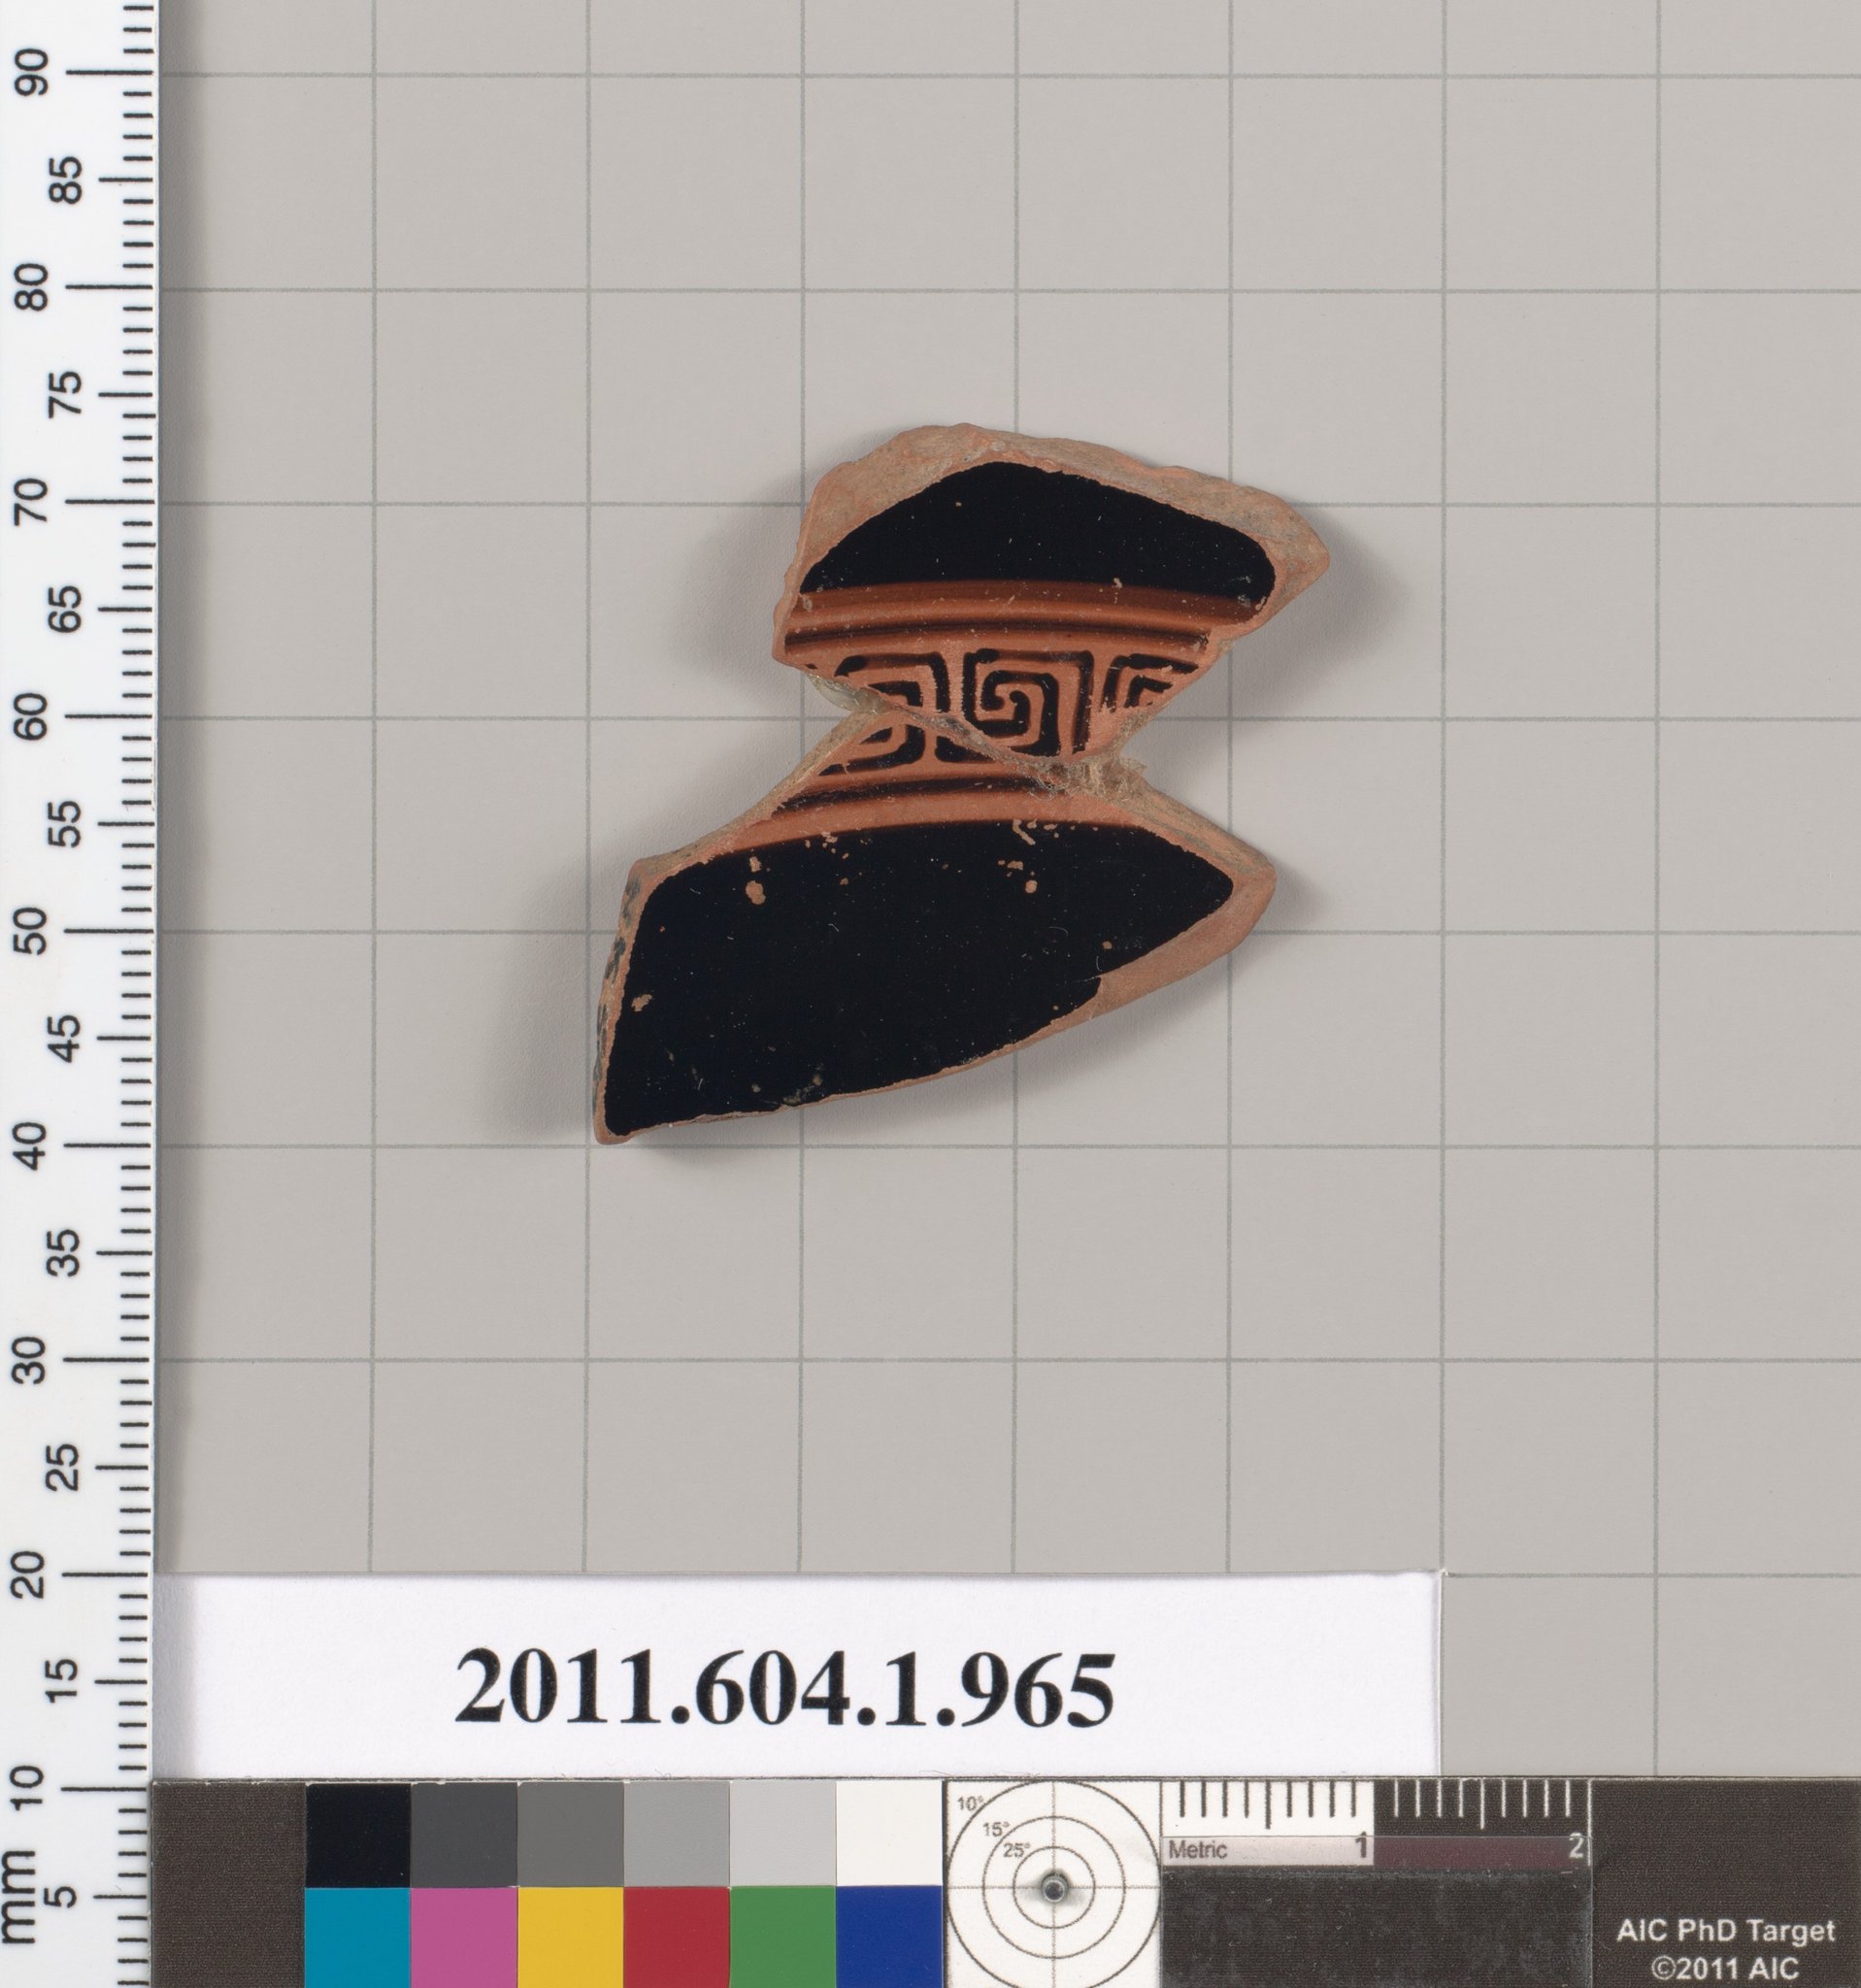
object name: kylix fragment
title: Terracotta fragment of a kylix (drinking cup)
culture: greek, attic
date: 490-480 BCE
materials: terracotta